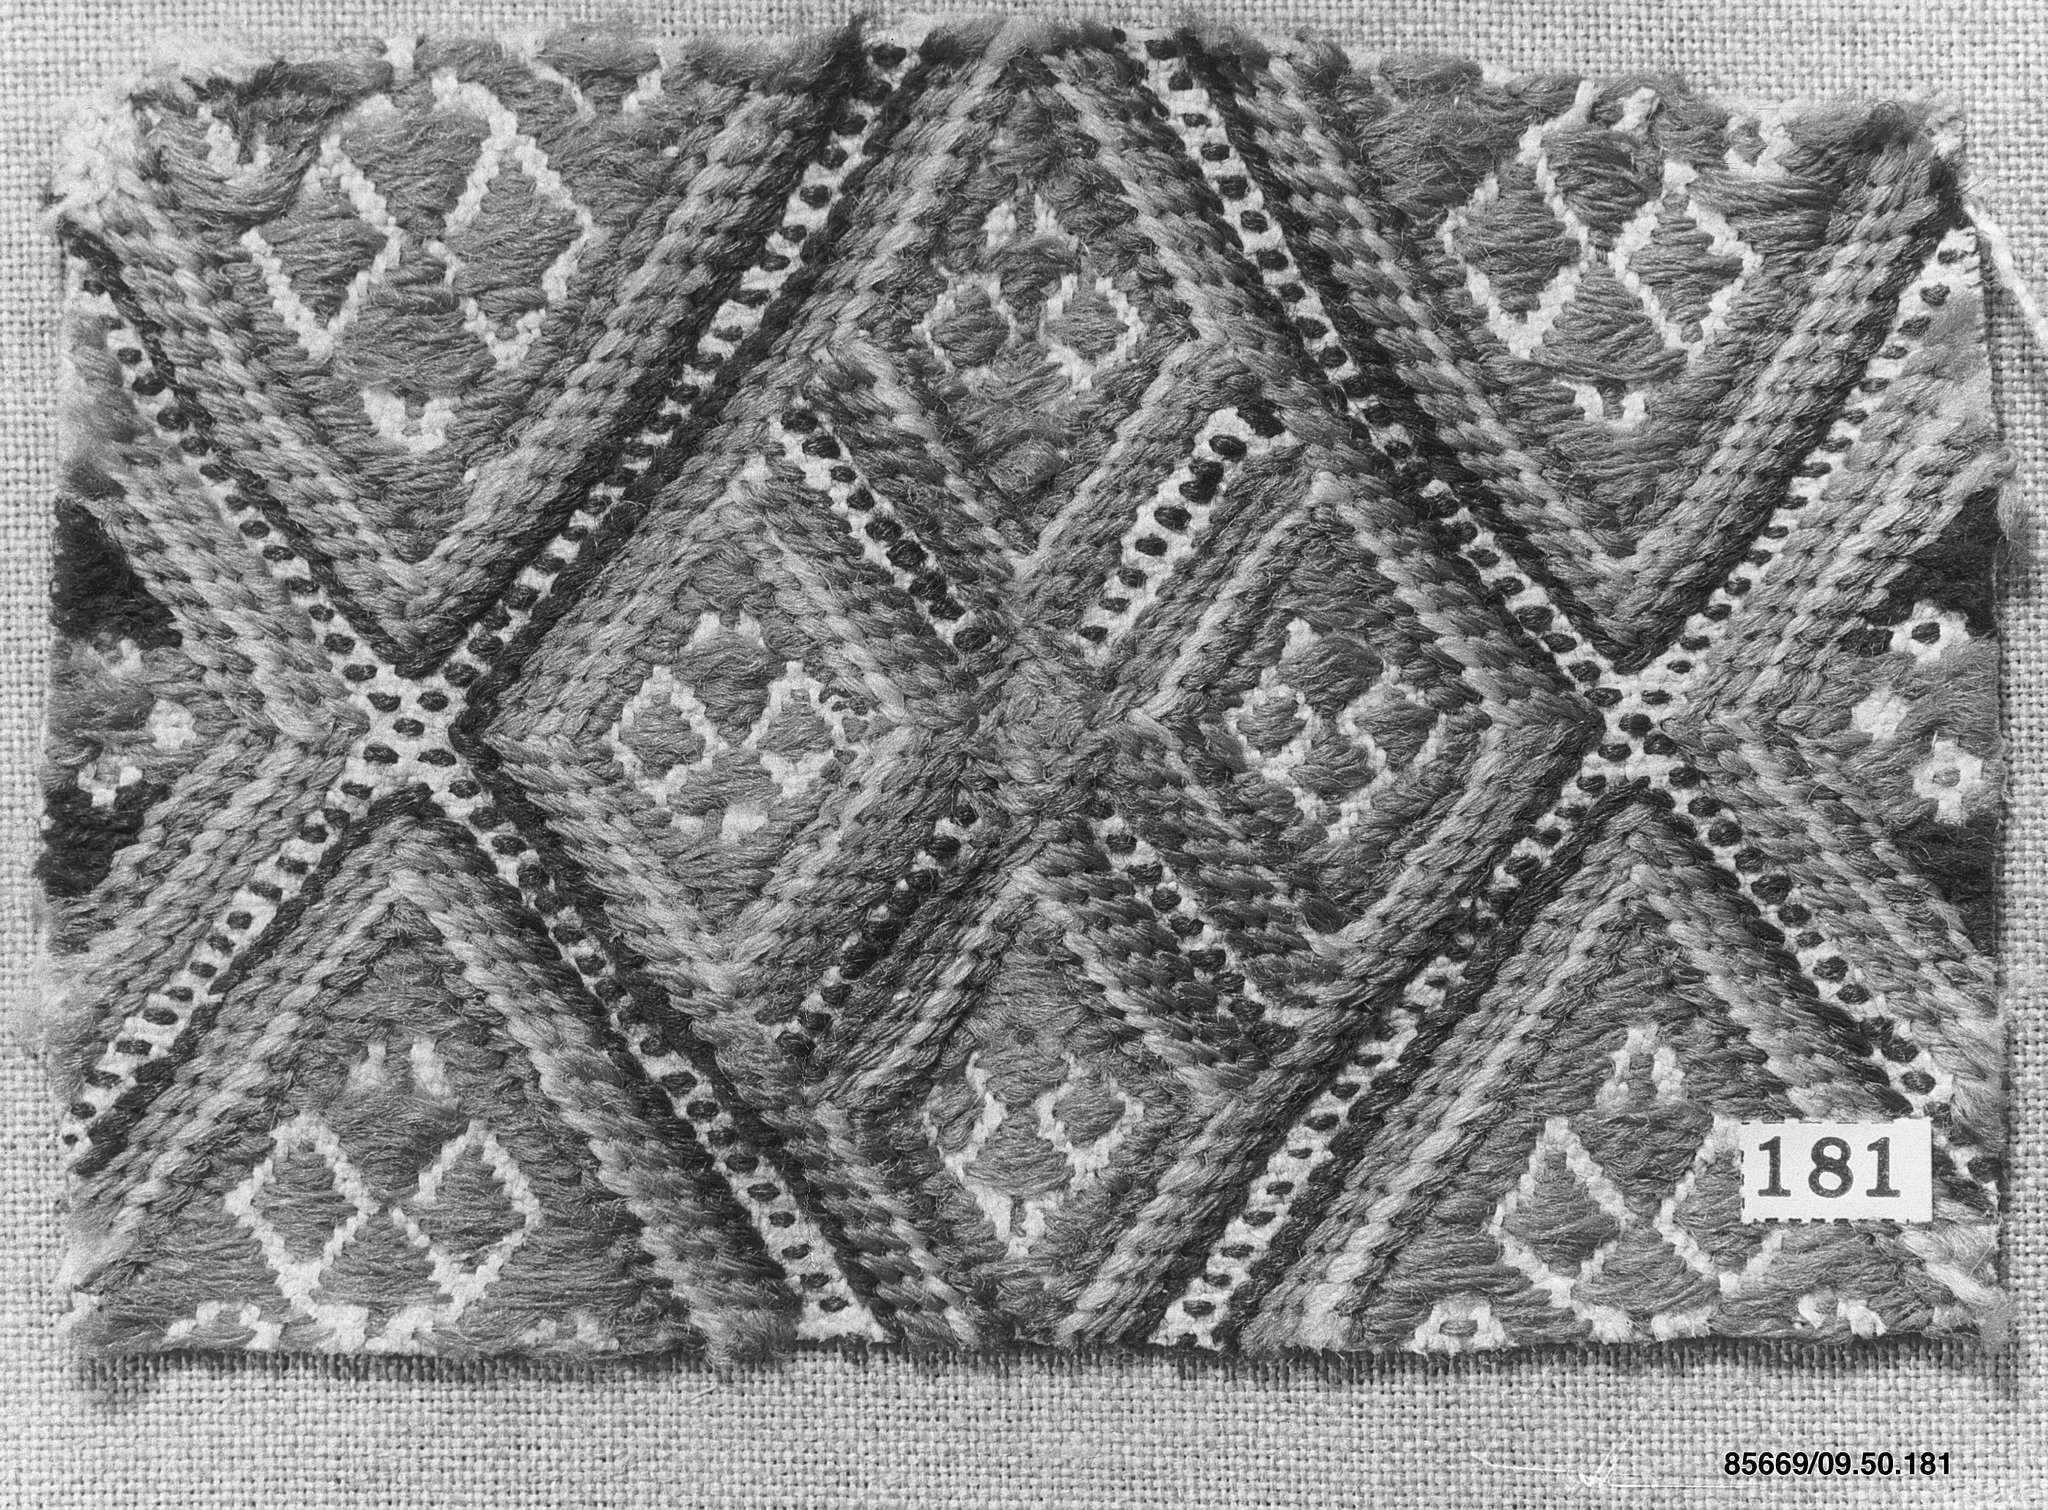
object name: costume fragment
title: Peasant costume fragment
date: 1701-1900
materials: canvas, wool